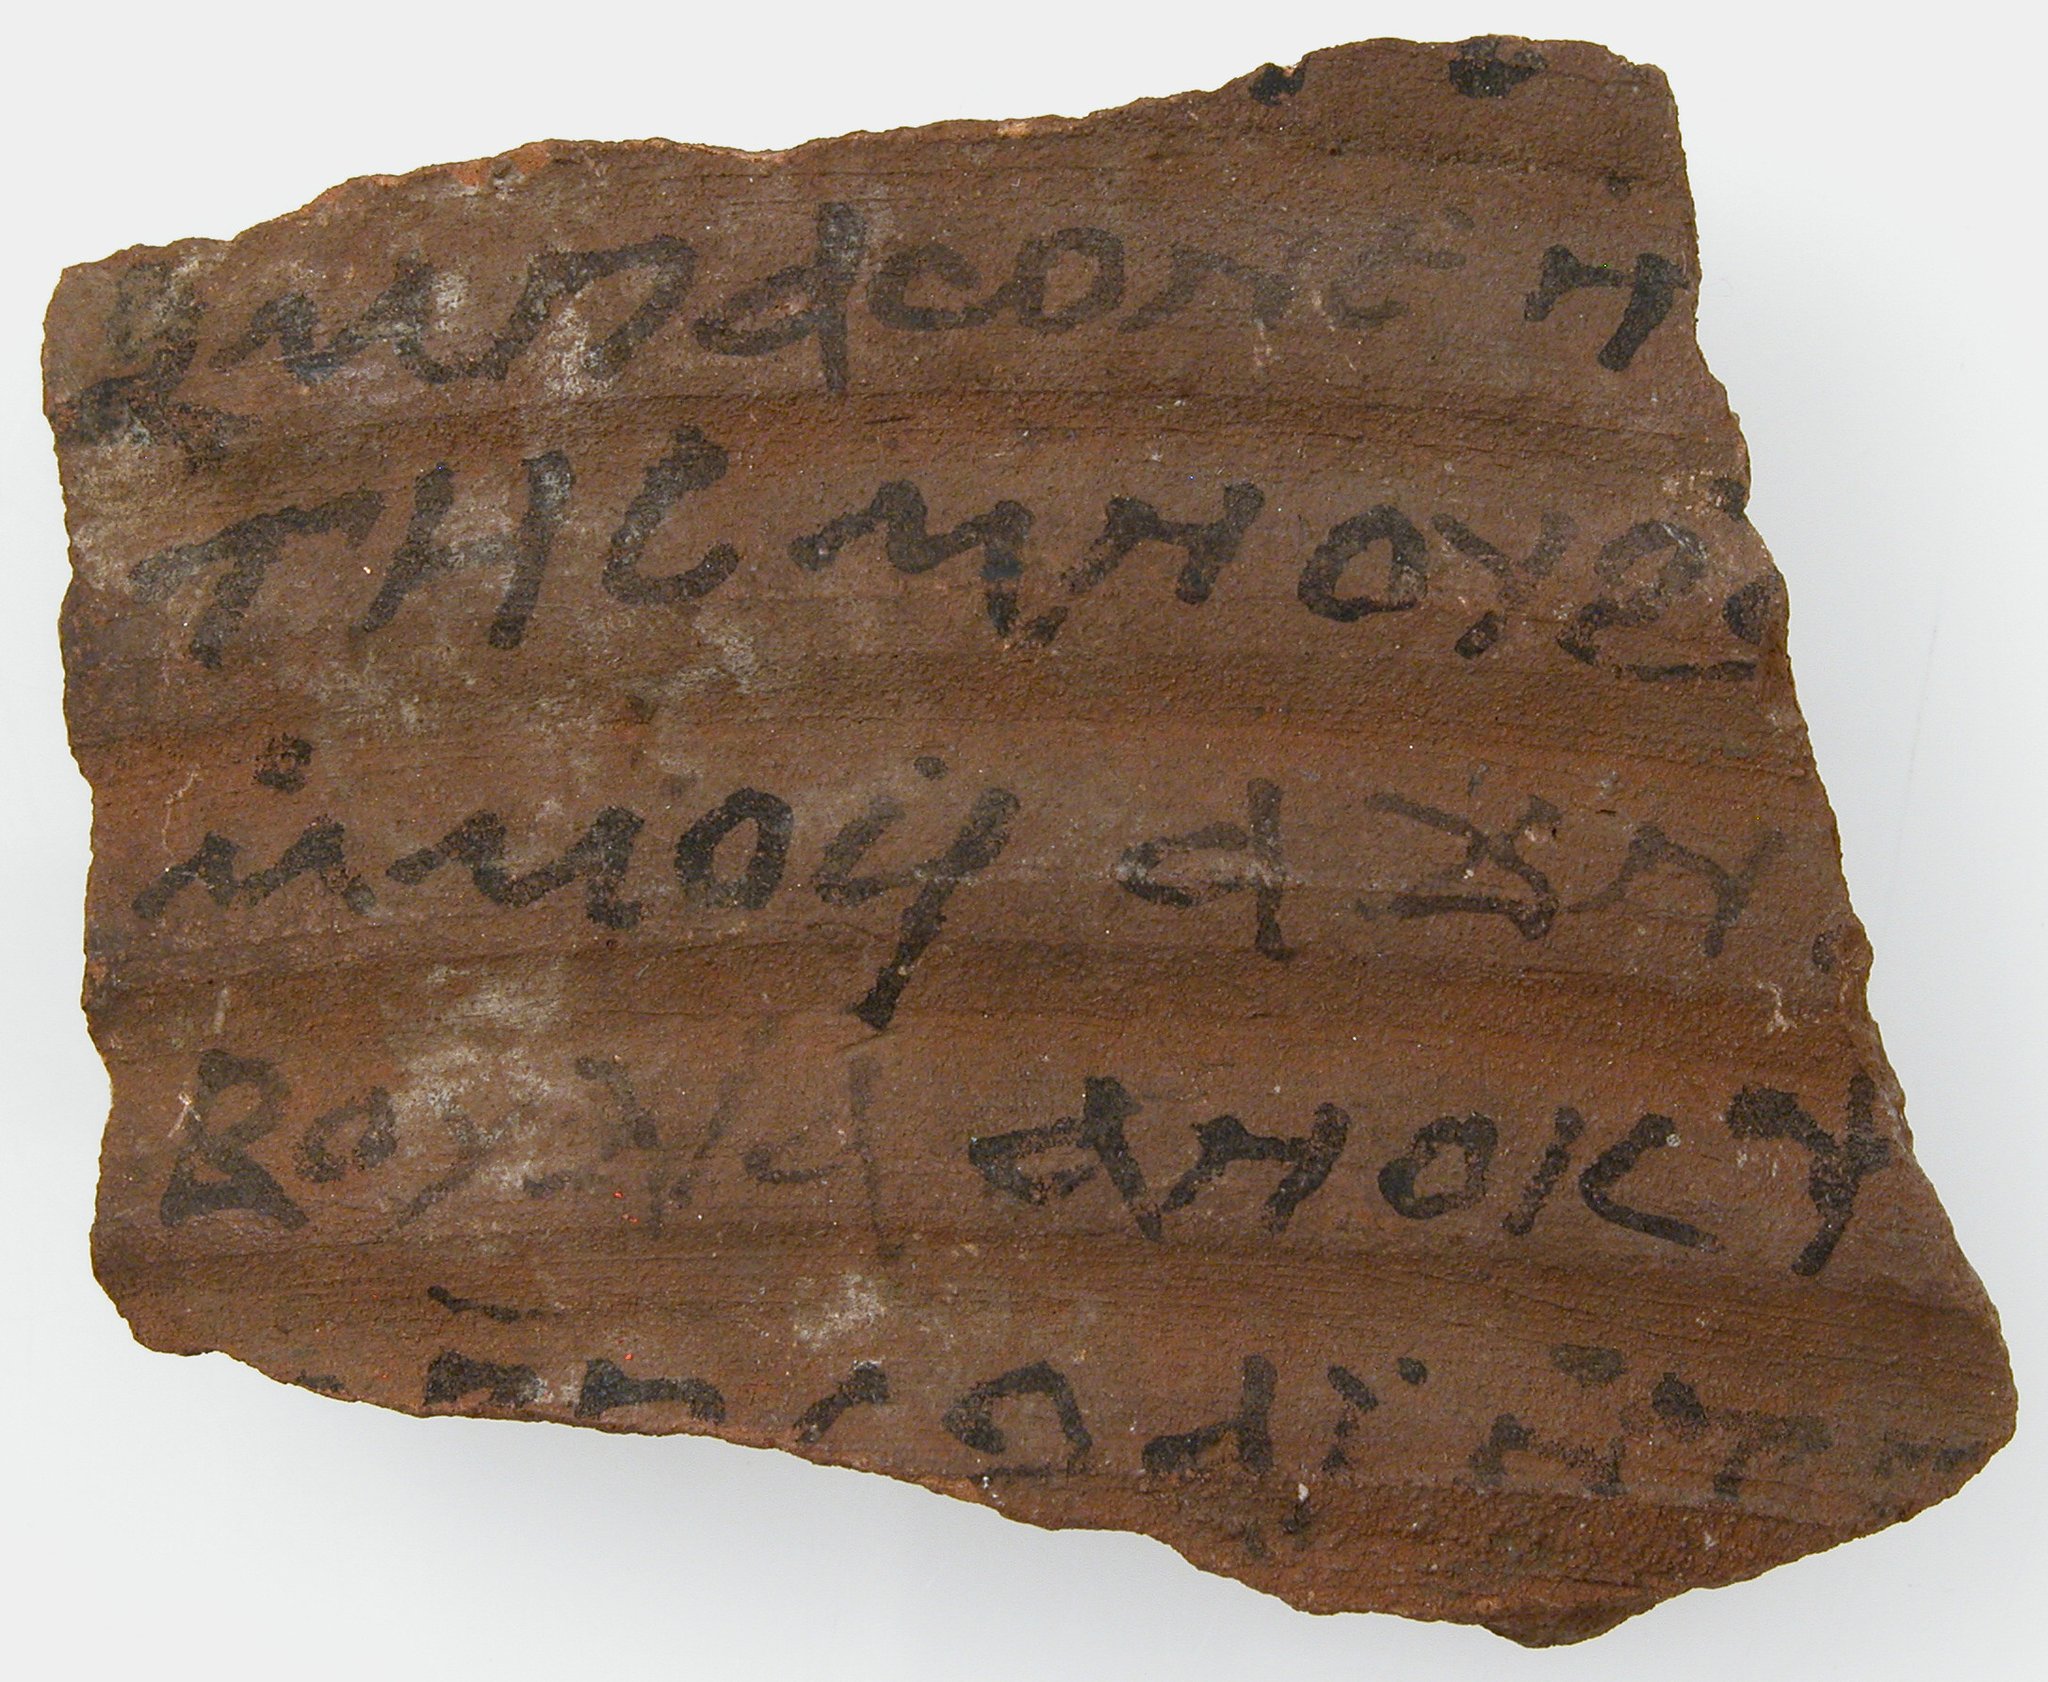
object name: ostrakon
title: Ostrakon with a Contract by Pses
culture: coptic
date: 600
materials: ink, pottery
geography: egypt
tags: coptic,documents